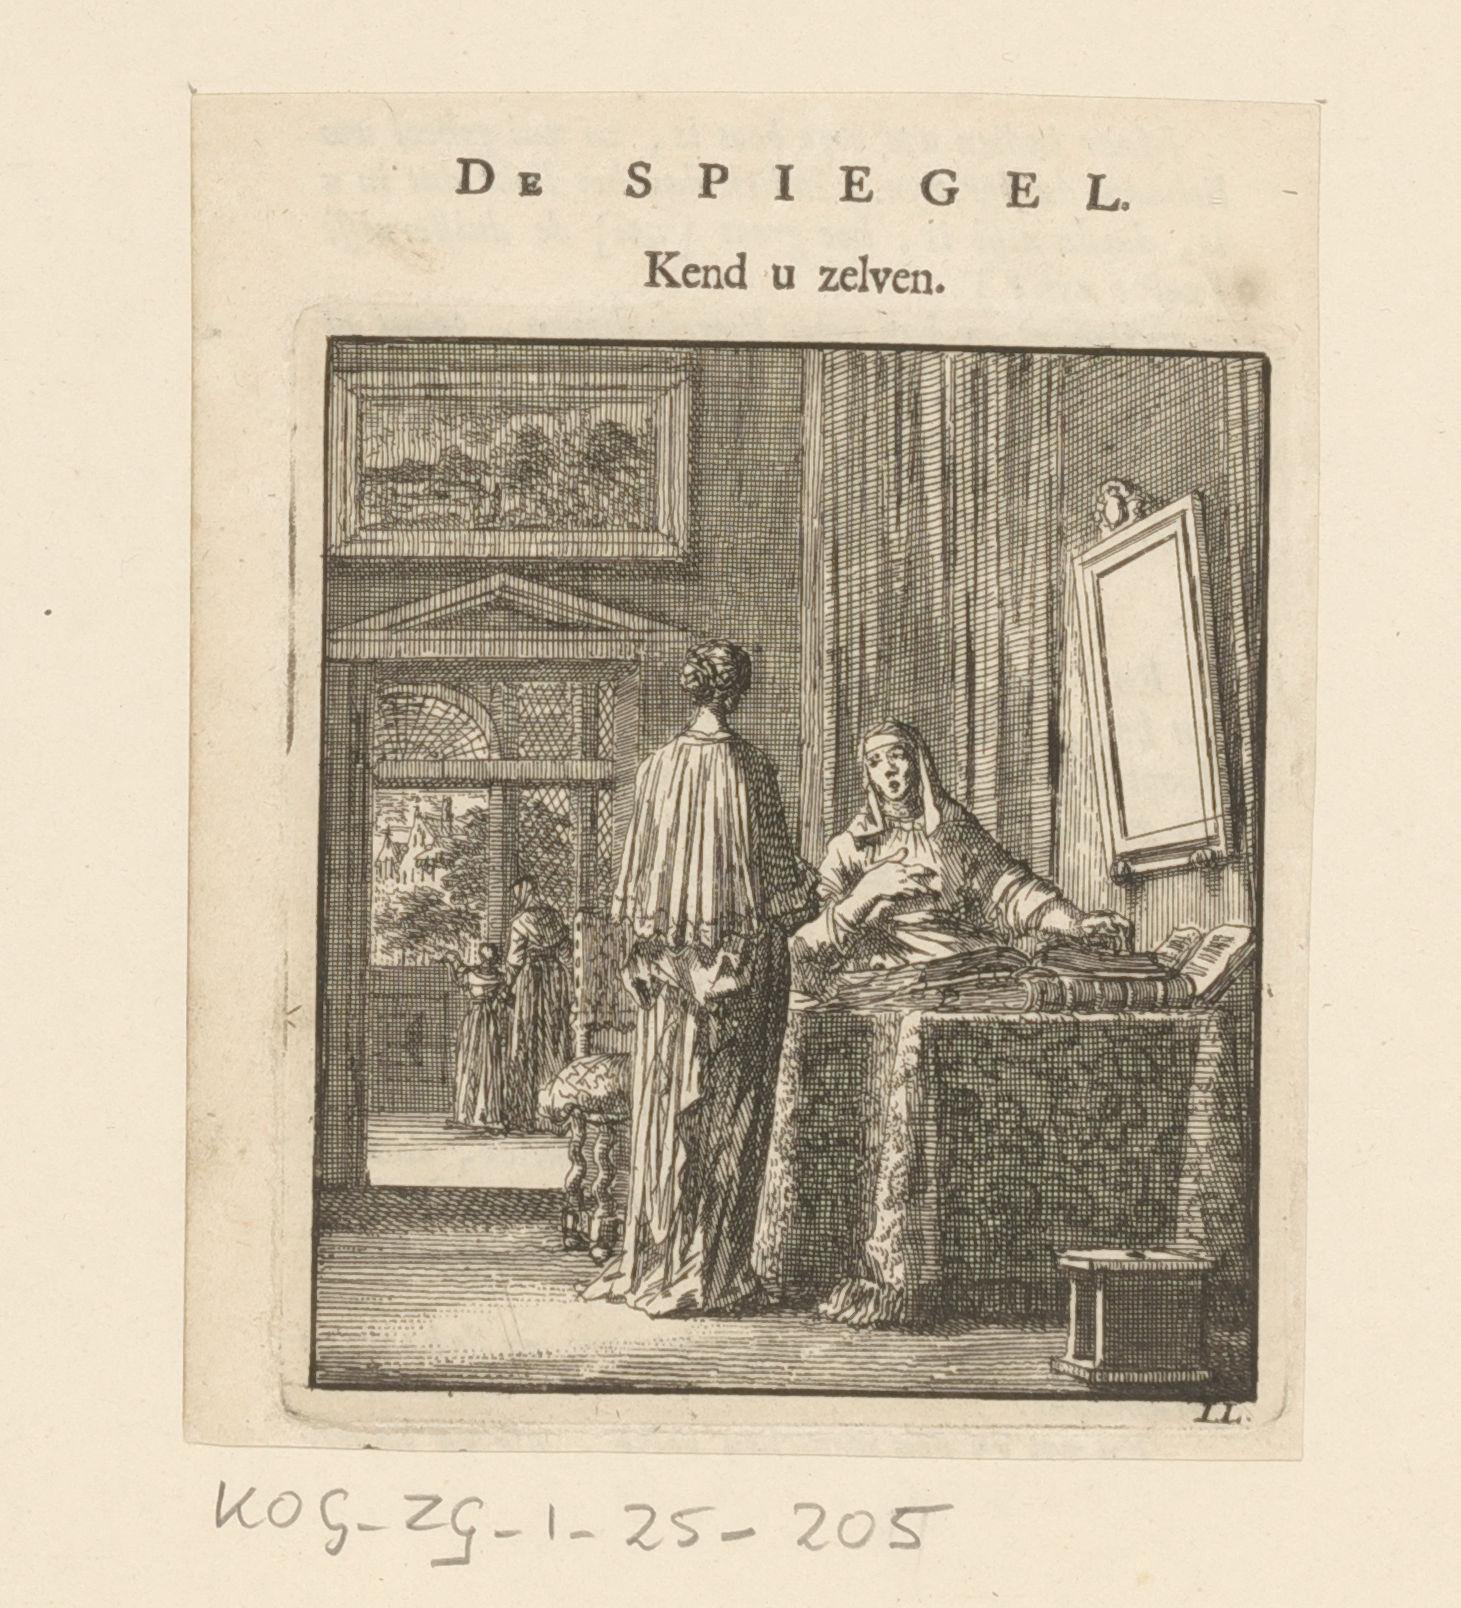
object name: book illustration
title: De Spiegel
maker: jan luyken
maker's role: draughtsman, print maker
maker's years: 1649-1712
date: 1711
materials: paper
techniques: etching, letterpress printing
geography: amsterdam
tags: reading, bible, mirror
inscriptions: stamp, collector's mark: Lugt 1641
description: Prent uit: Luyken, Jan. Het leerzaam huisraad, vertoond in vyftig konstige figuuren, met godlyke spreuken en stichtelyke verzen. Amsterdam: weduwe Pieter Arentsz. II en Cornelis van der Sys, 1711, p. 54.